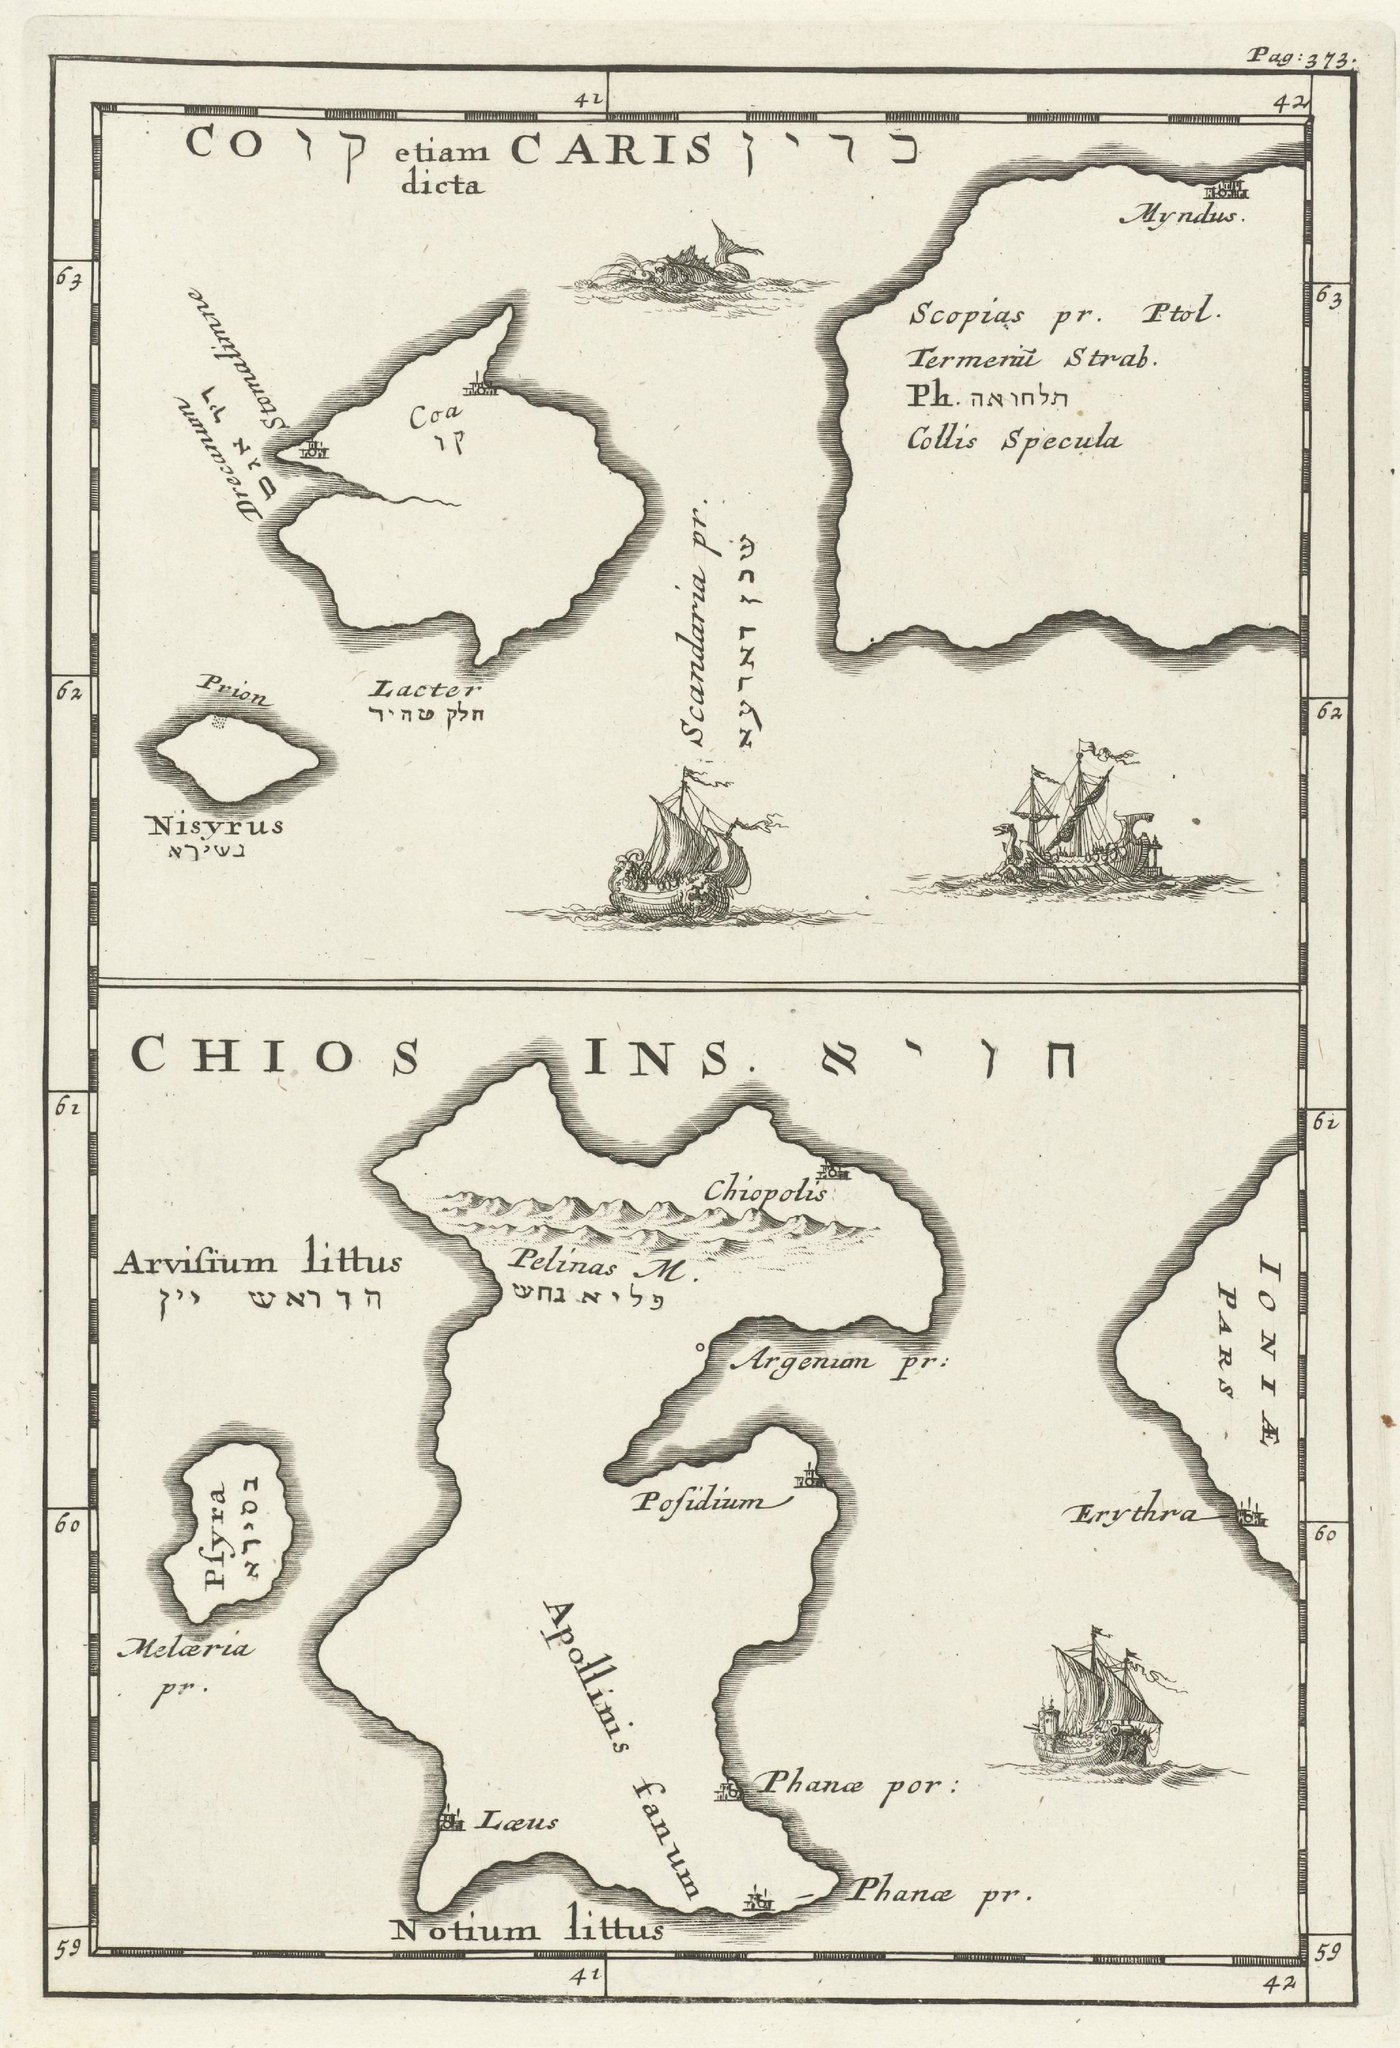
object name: book illustration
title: Kaarten van Kos en Chios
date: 1692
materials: paper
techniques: etching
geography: leiden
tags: maps of separate countries or regions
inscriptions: collector's mark: Lugt 2228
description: Illustratie uit: Bochart, Samuel. Opera Omnia (...). Editio tertia, 2 delen. Leiden: Cornelis Boutesteyn en Jordaan Luchtmans, 1692, dl. I.